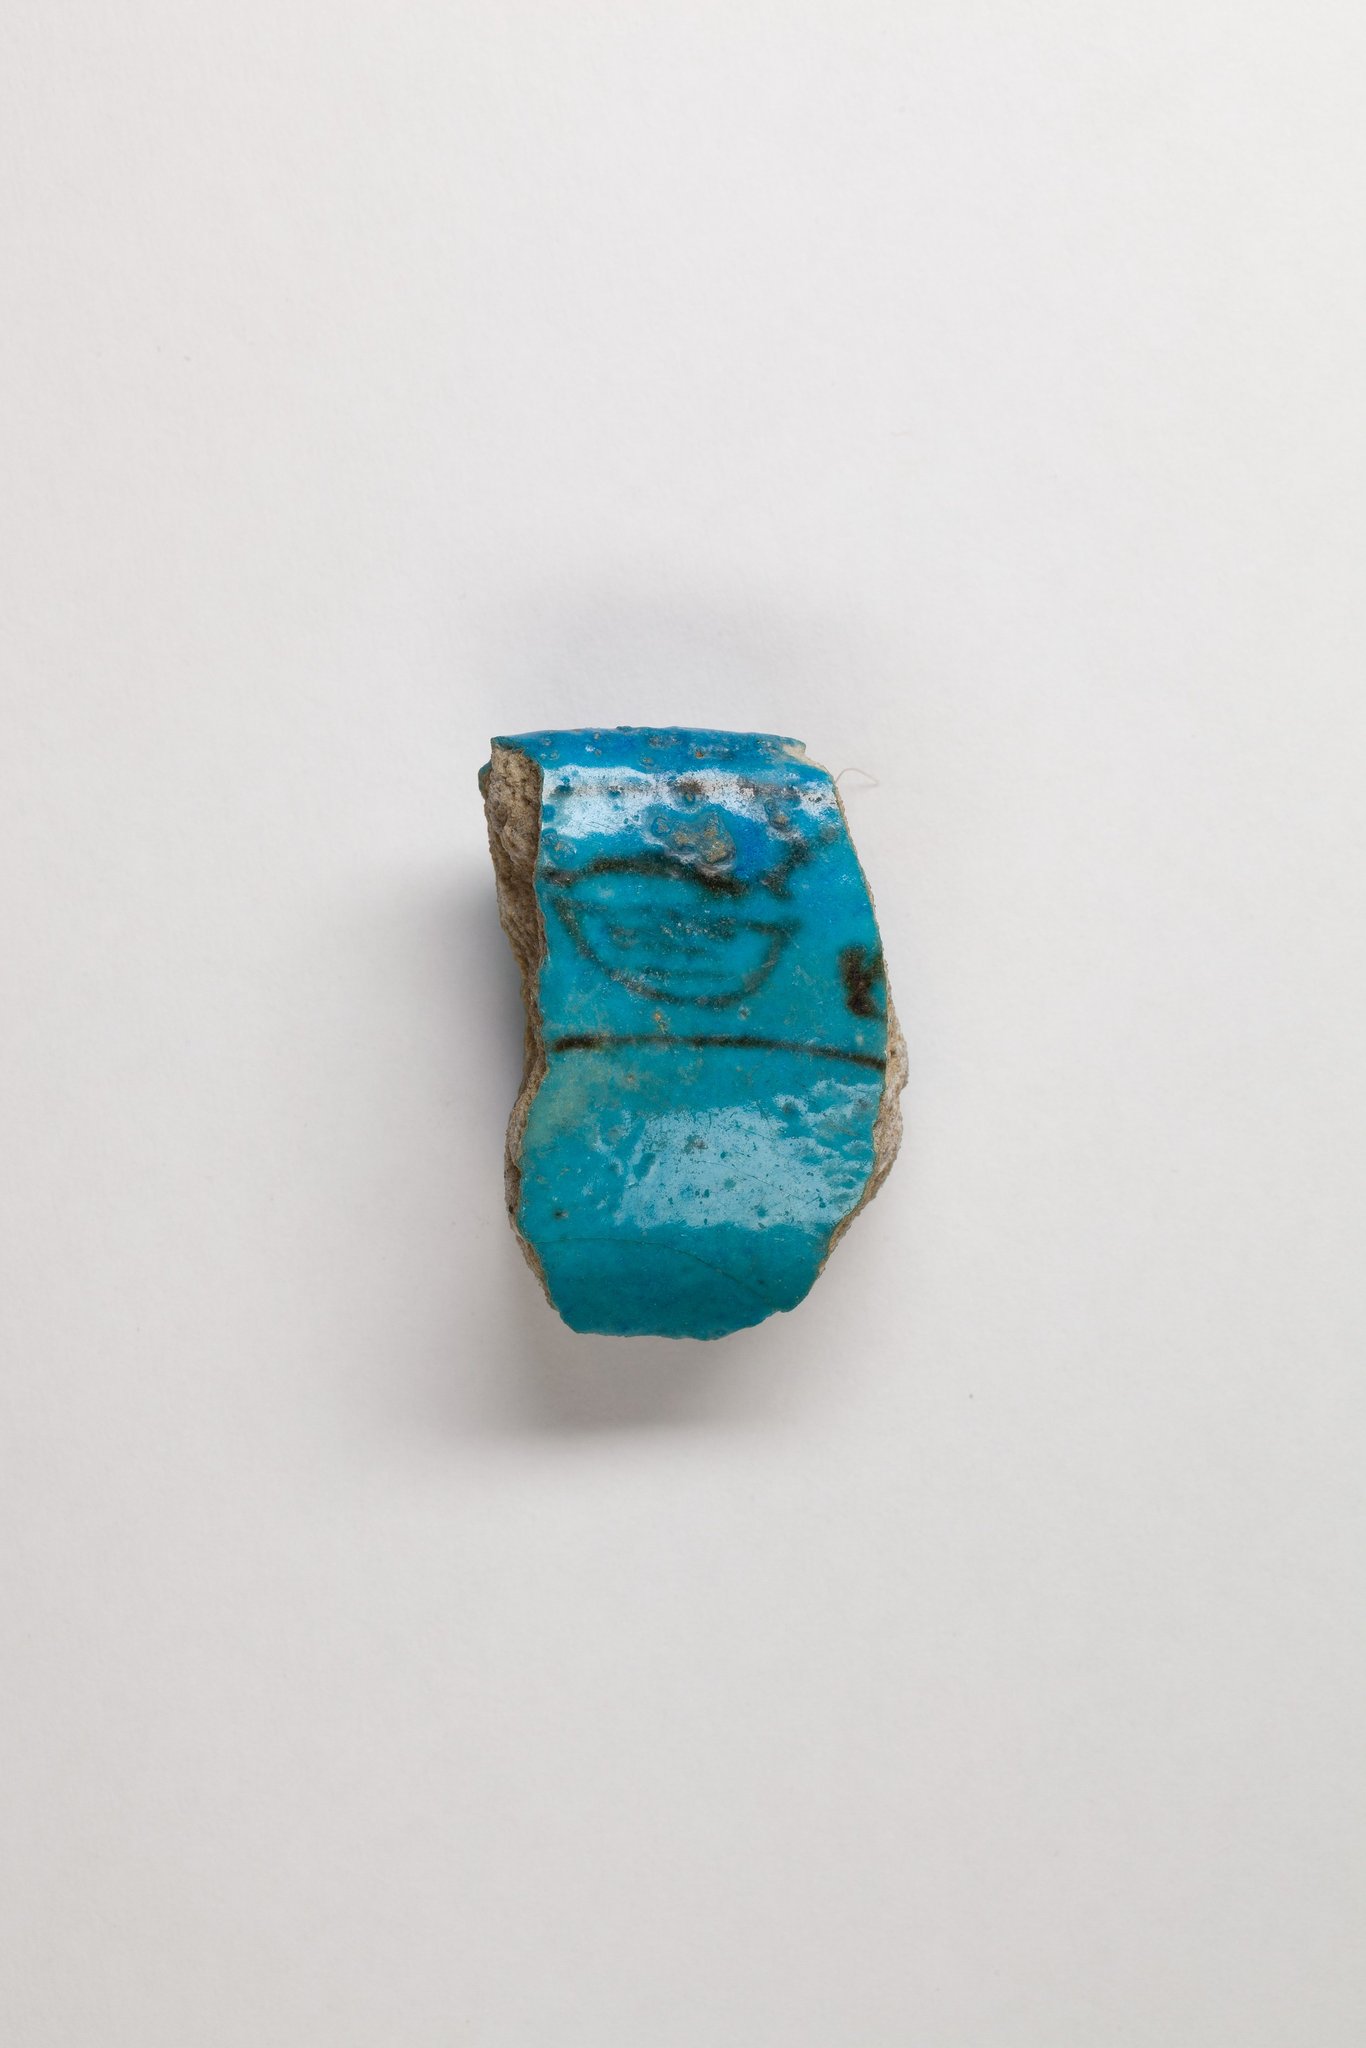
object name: vase fragment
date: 1981-1640 BCE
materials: faience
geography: egypt